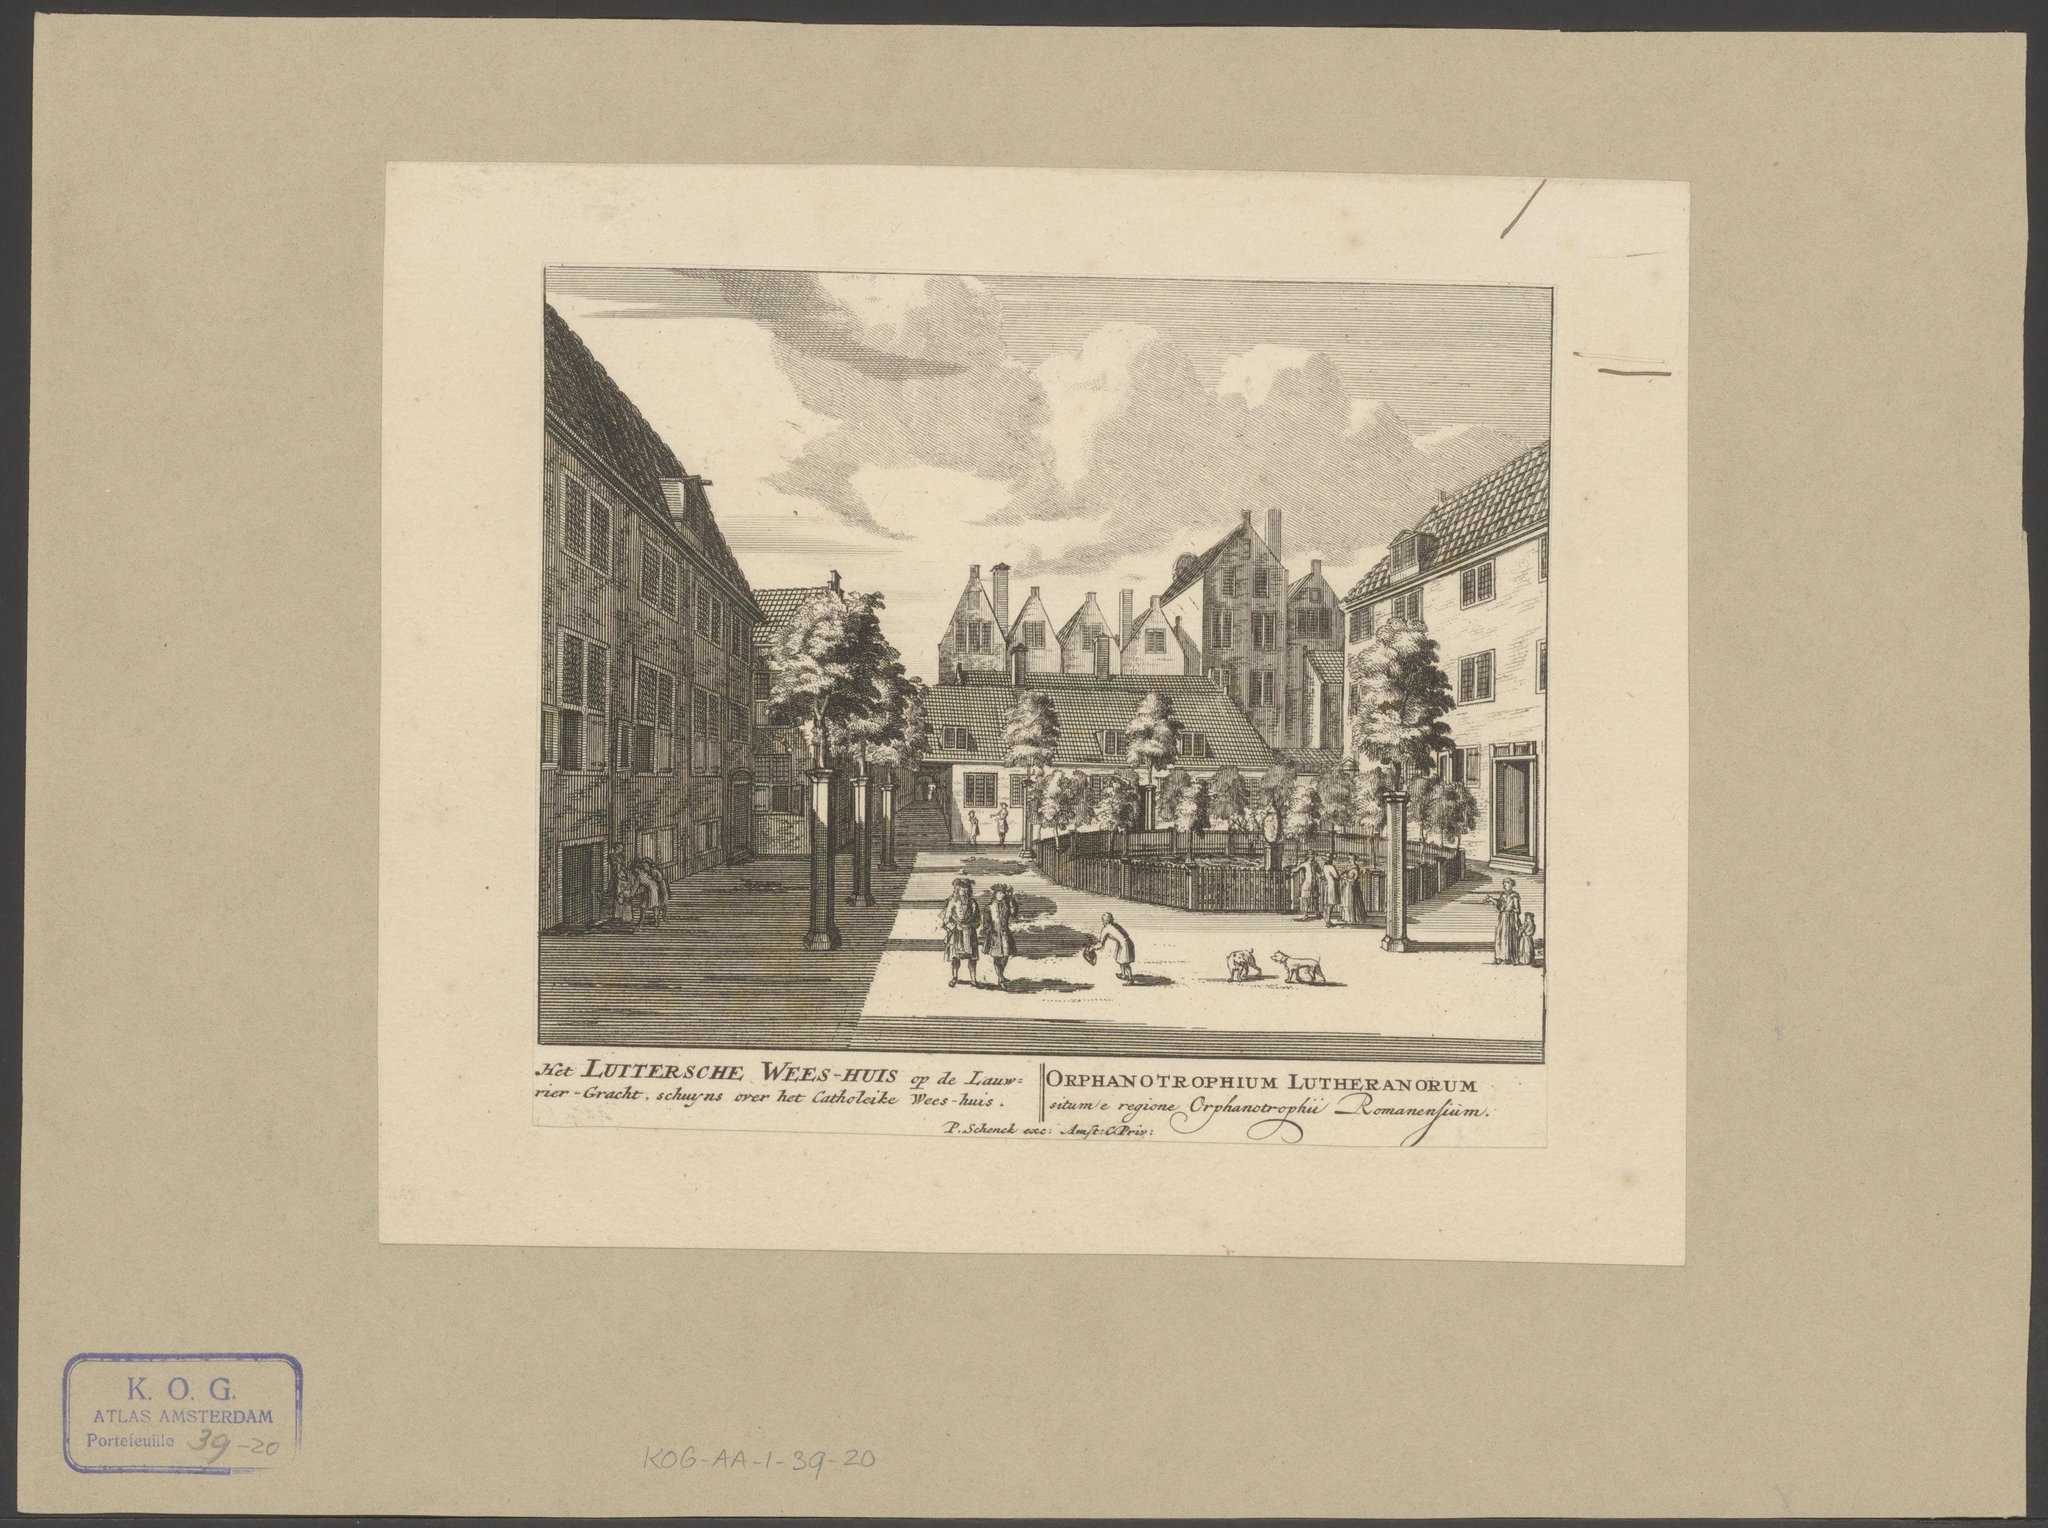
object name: print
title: Het Luitersche Wees-huis op de Lauwrier-Gracht, schuyns over het Catholeike Wees-huis / Orphanotrophium Lutheranorum situm e regione Orphanotrophii Romanensium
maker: Anonymous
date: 1710-1711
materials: paper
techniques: engraving, etching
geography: northern netherlands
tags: courtyard, orphanage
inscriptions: collector's mark: Lugt 1641b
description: Prent mogelijk uit: 100 Afbeeldinge der voornaamste gebouwen van Amsterdam. Amsterdam: Pieter Schenk (I), s.a. [1710-1711]. Of uit: 100 Afbeeldinge der voornaamste gebouwen van Amsterdam. Amsterdam: Barent Greve, s.a. [1757-1766]. In de tweede uitgave, uitgegeven door Barent Greve, is alleen de titelprent aangepast. De overige prenten zijn onveranderd gebleven.